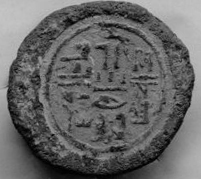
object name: cone, circular impression, min, scribe, overseer, priest, osiris, oasis, tt 109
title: Funerary Cone of the Scribe Min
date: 1479-1425 BCE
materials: pottery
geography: egypt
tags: hieroglyphs